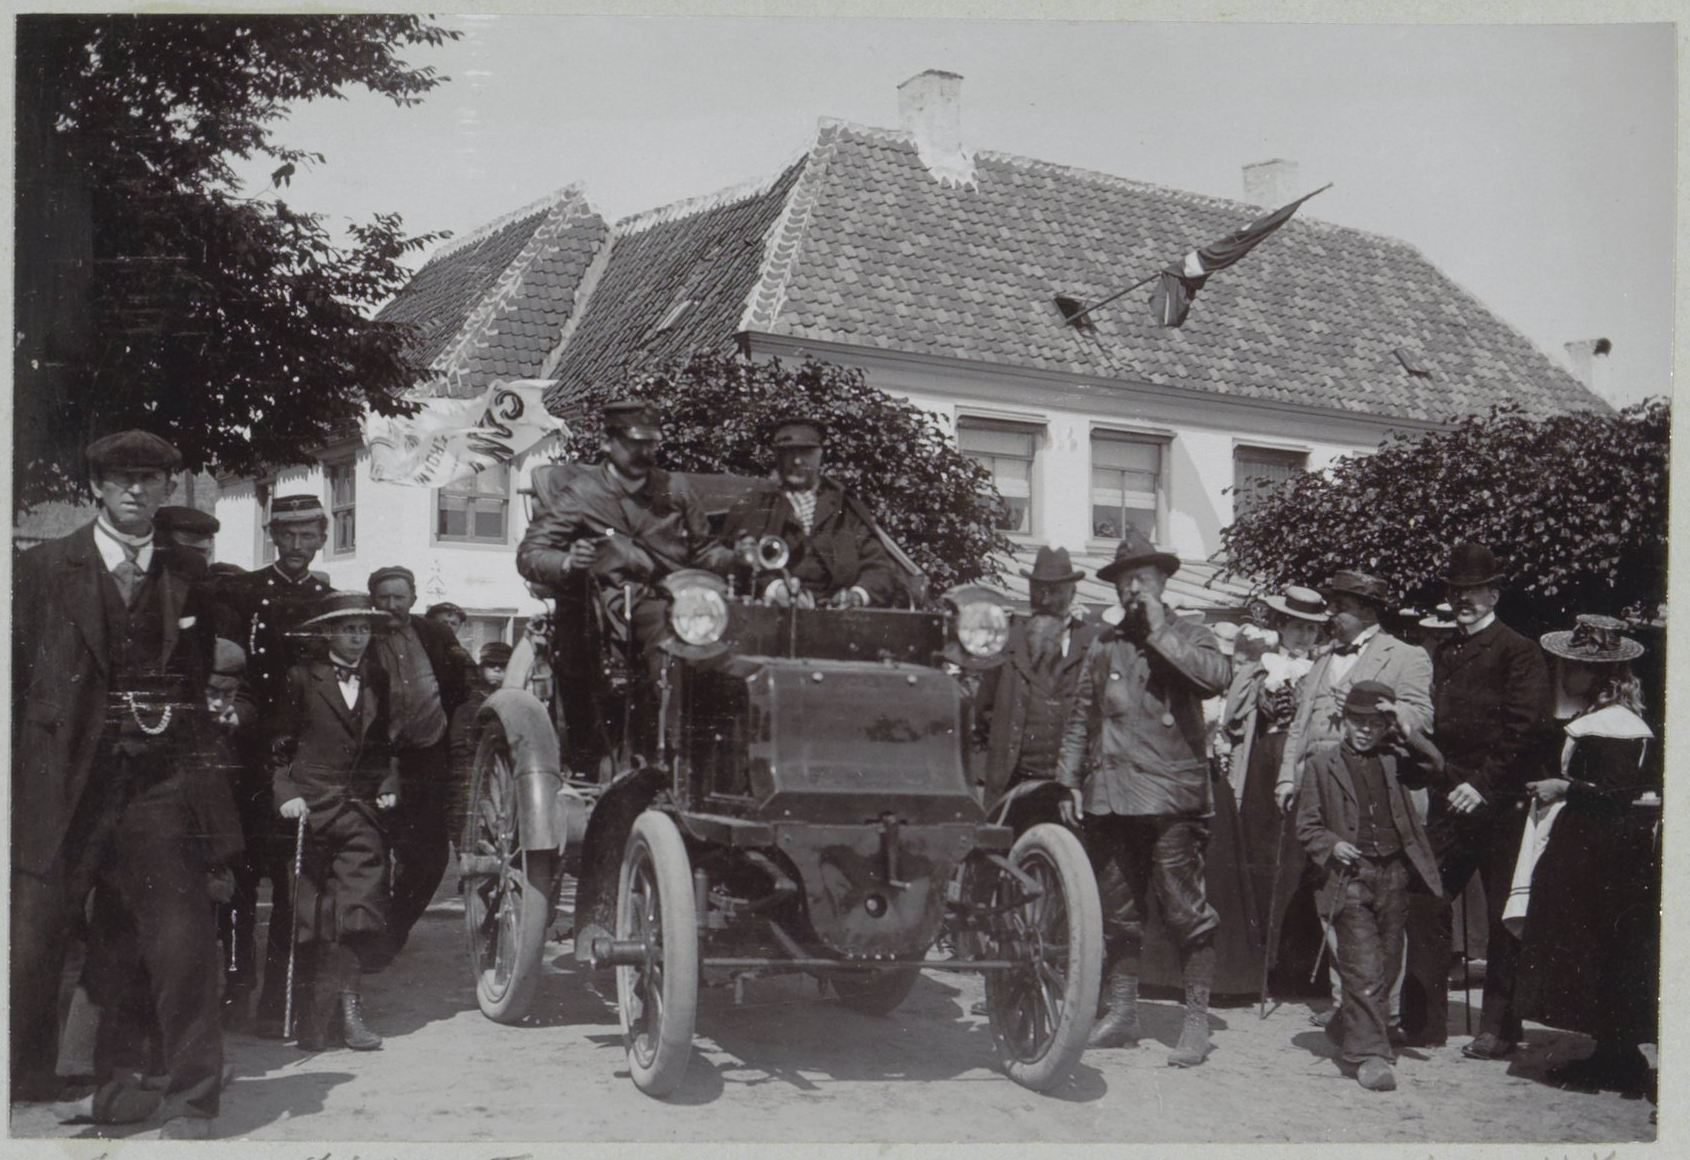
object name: photograph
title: Gournu en Le Vieux Frère, deelnemers aan de race Parijs-Amsterdam in hun automobiel, vermoedelijk in de regio Nijmegen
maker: delizy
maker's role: manufacturer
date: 1807-1898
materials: paper, photographic support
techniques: collodion silver print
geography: nijmegen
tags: motorcar racing, automobile, nijmegen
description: Onderdeel van Fotoalbum van een Franse amateurfotograaf met opnames van uitstapjes in Frankrijk, Spanje, België, Luxemburg en Nederland, de eerste automobielen en autoraces.